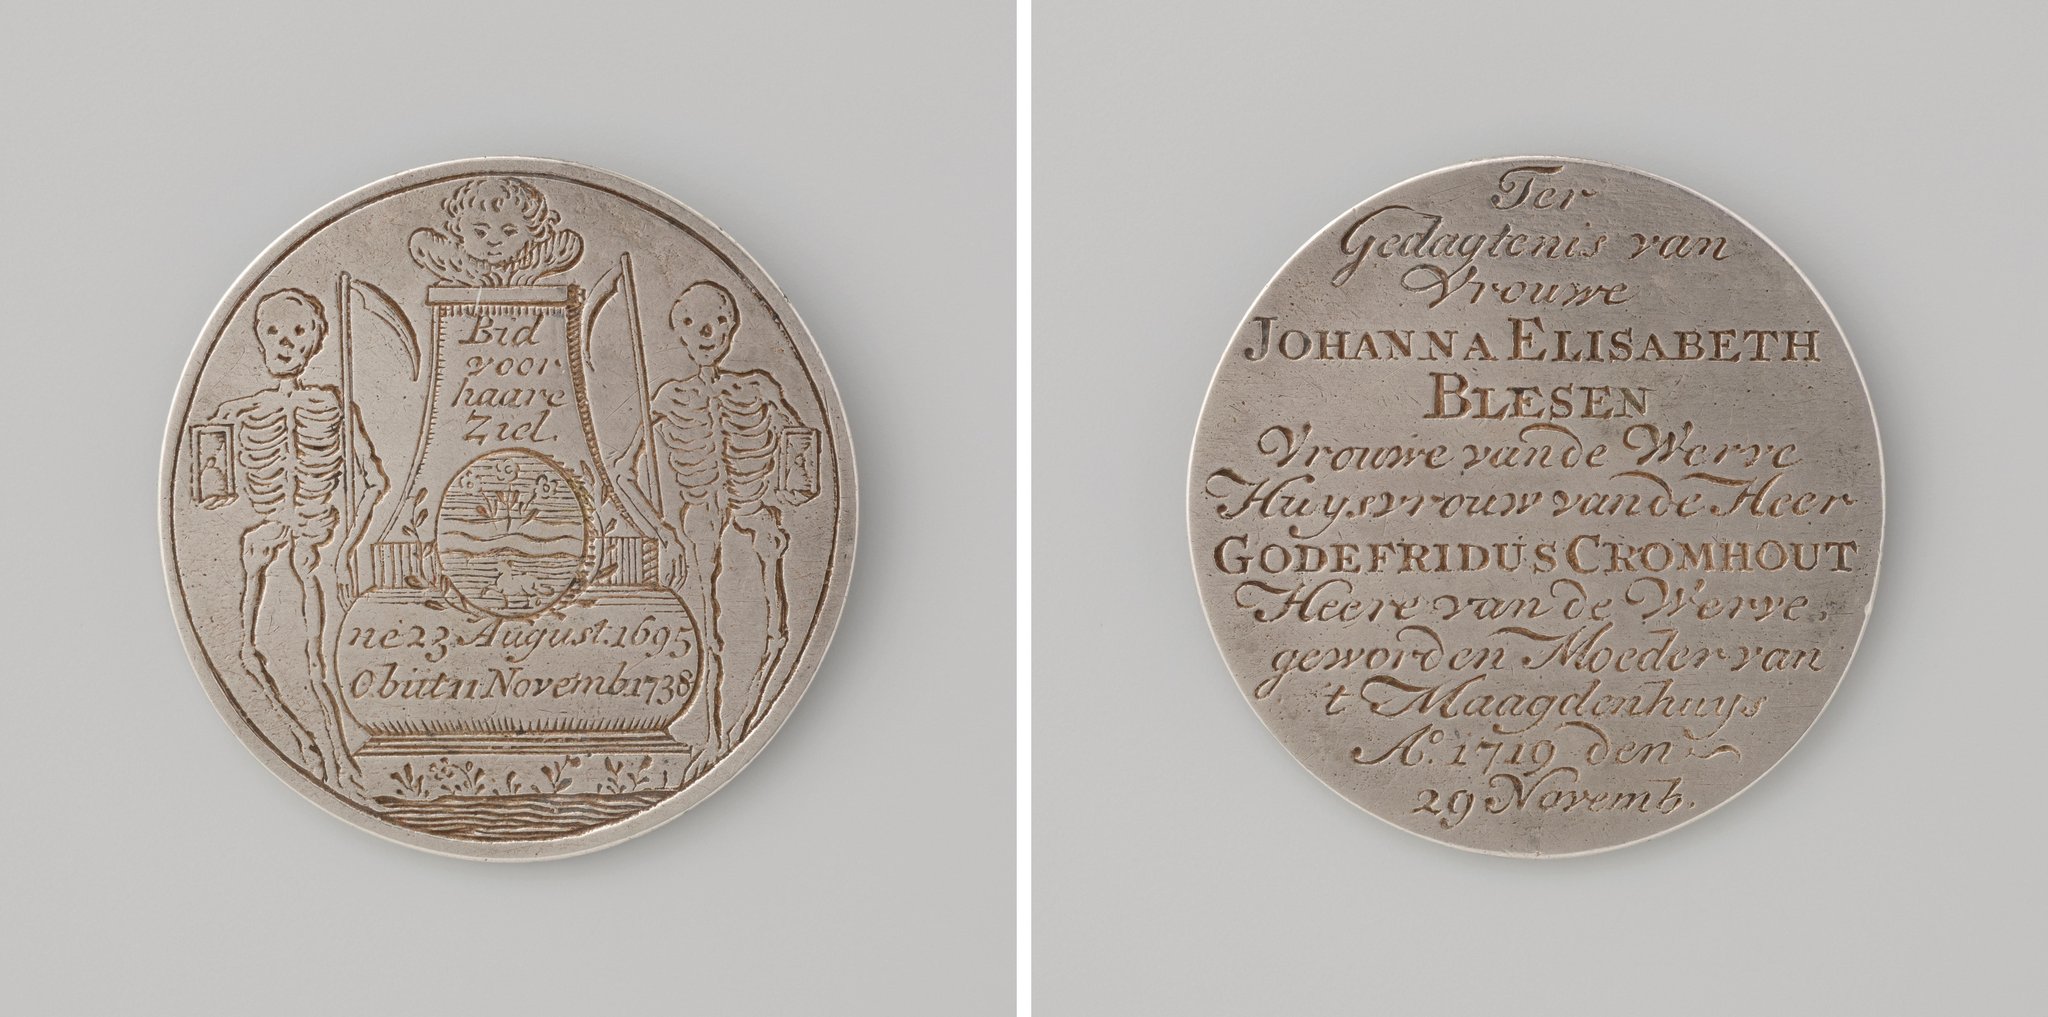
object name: overlijdenspenning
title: Overlijden van Johanna Elisabeth Blesen, vrouw van Godfried Cromhout, moeder van het Maagdenhuis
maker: Anonymous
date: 1738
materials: silver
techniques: engraving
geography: netherlands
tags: johanna elisabeth blesen, godfried cromhout, rooms-katholiek maagdenhuis (amsterdam)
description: Zilveren penning. Voorzijde: twee geraamtes met zandloper en zeis staande aan weerszijden van grafmonument met opschrift en wapenschild omgeven door twee samengebonden olijftakken en bekroond met hoofd. Keerzijde: opschrift.